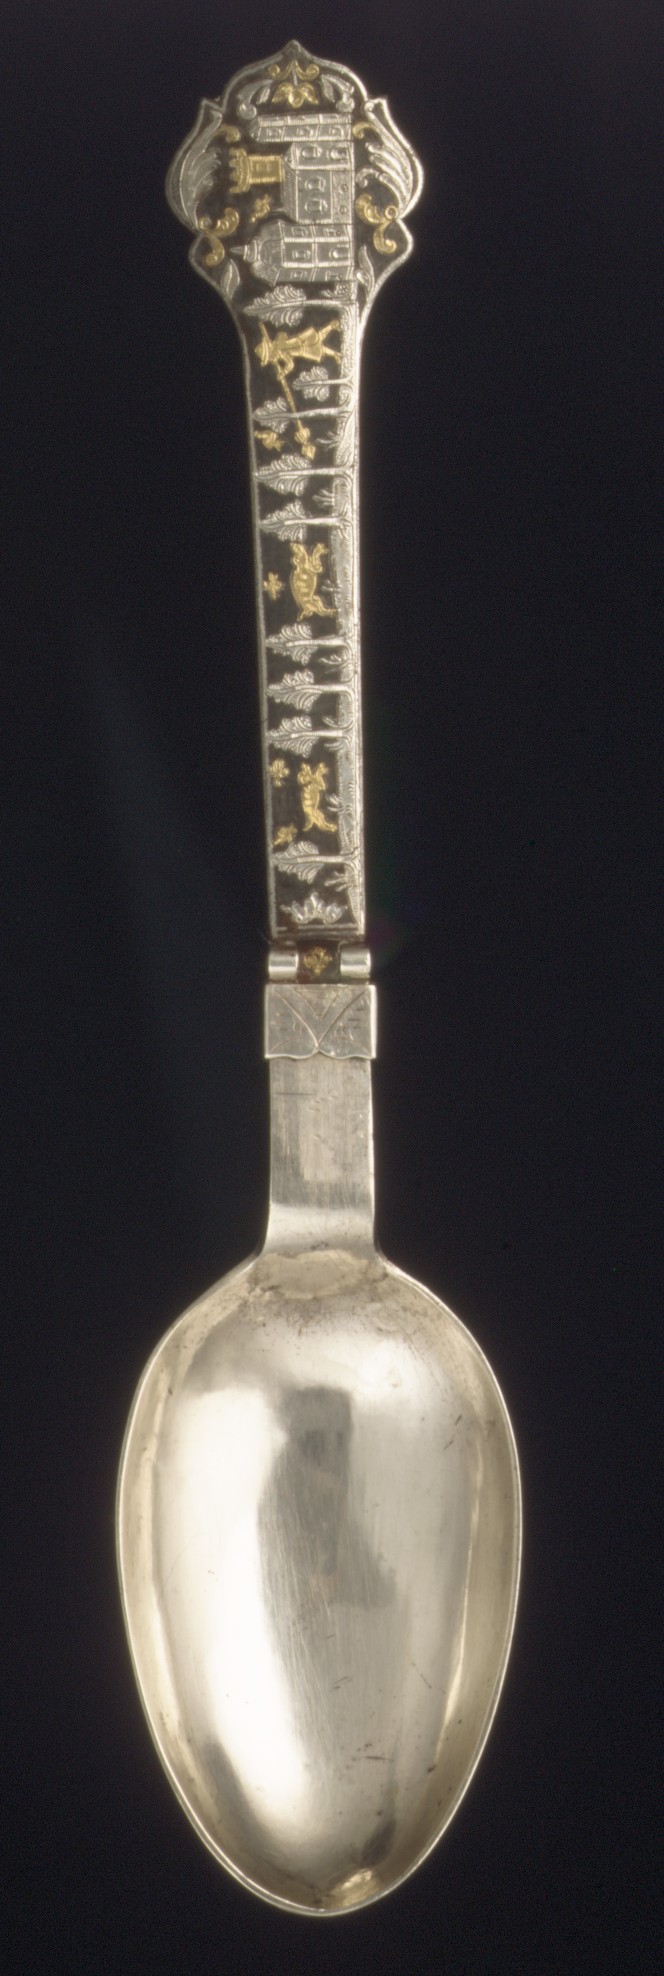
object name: spoon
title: Folding spoon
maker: johann adam boller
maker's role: maker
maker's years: 1706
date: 1701-1733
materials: gold, silver, steel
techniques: inlay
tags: animals,castles,men,trees